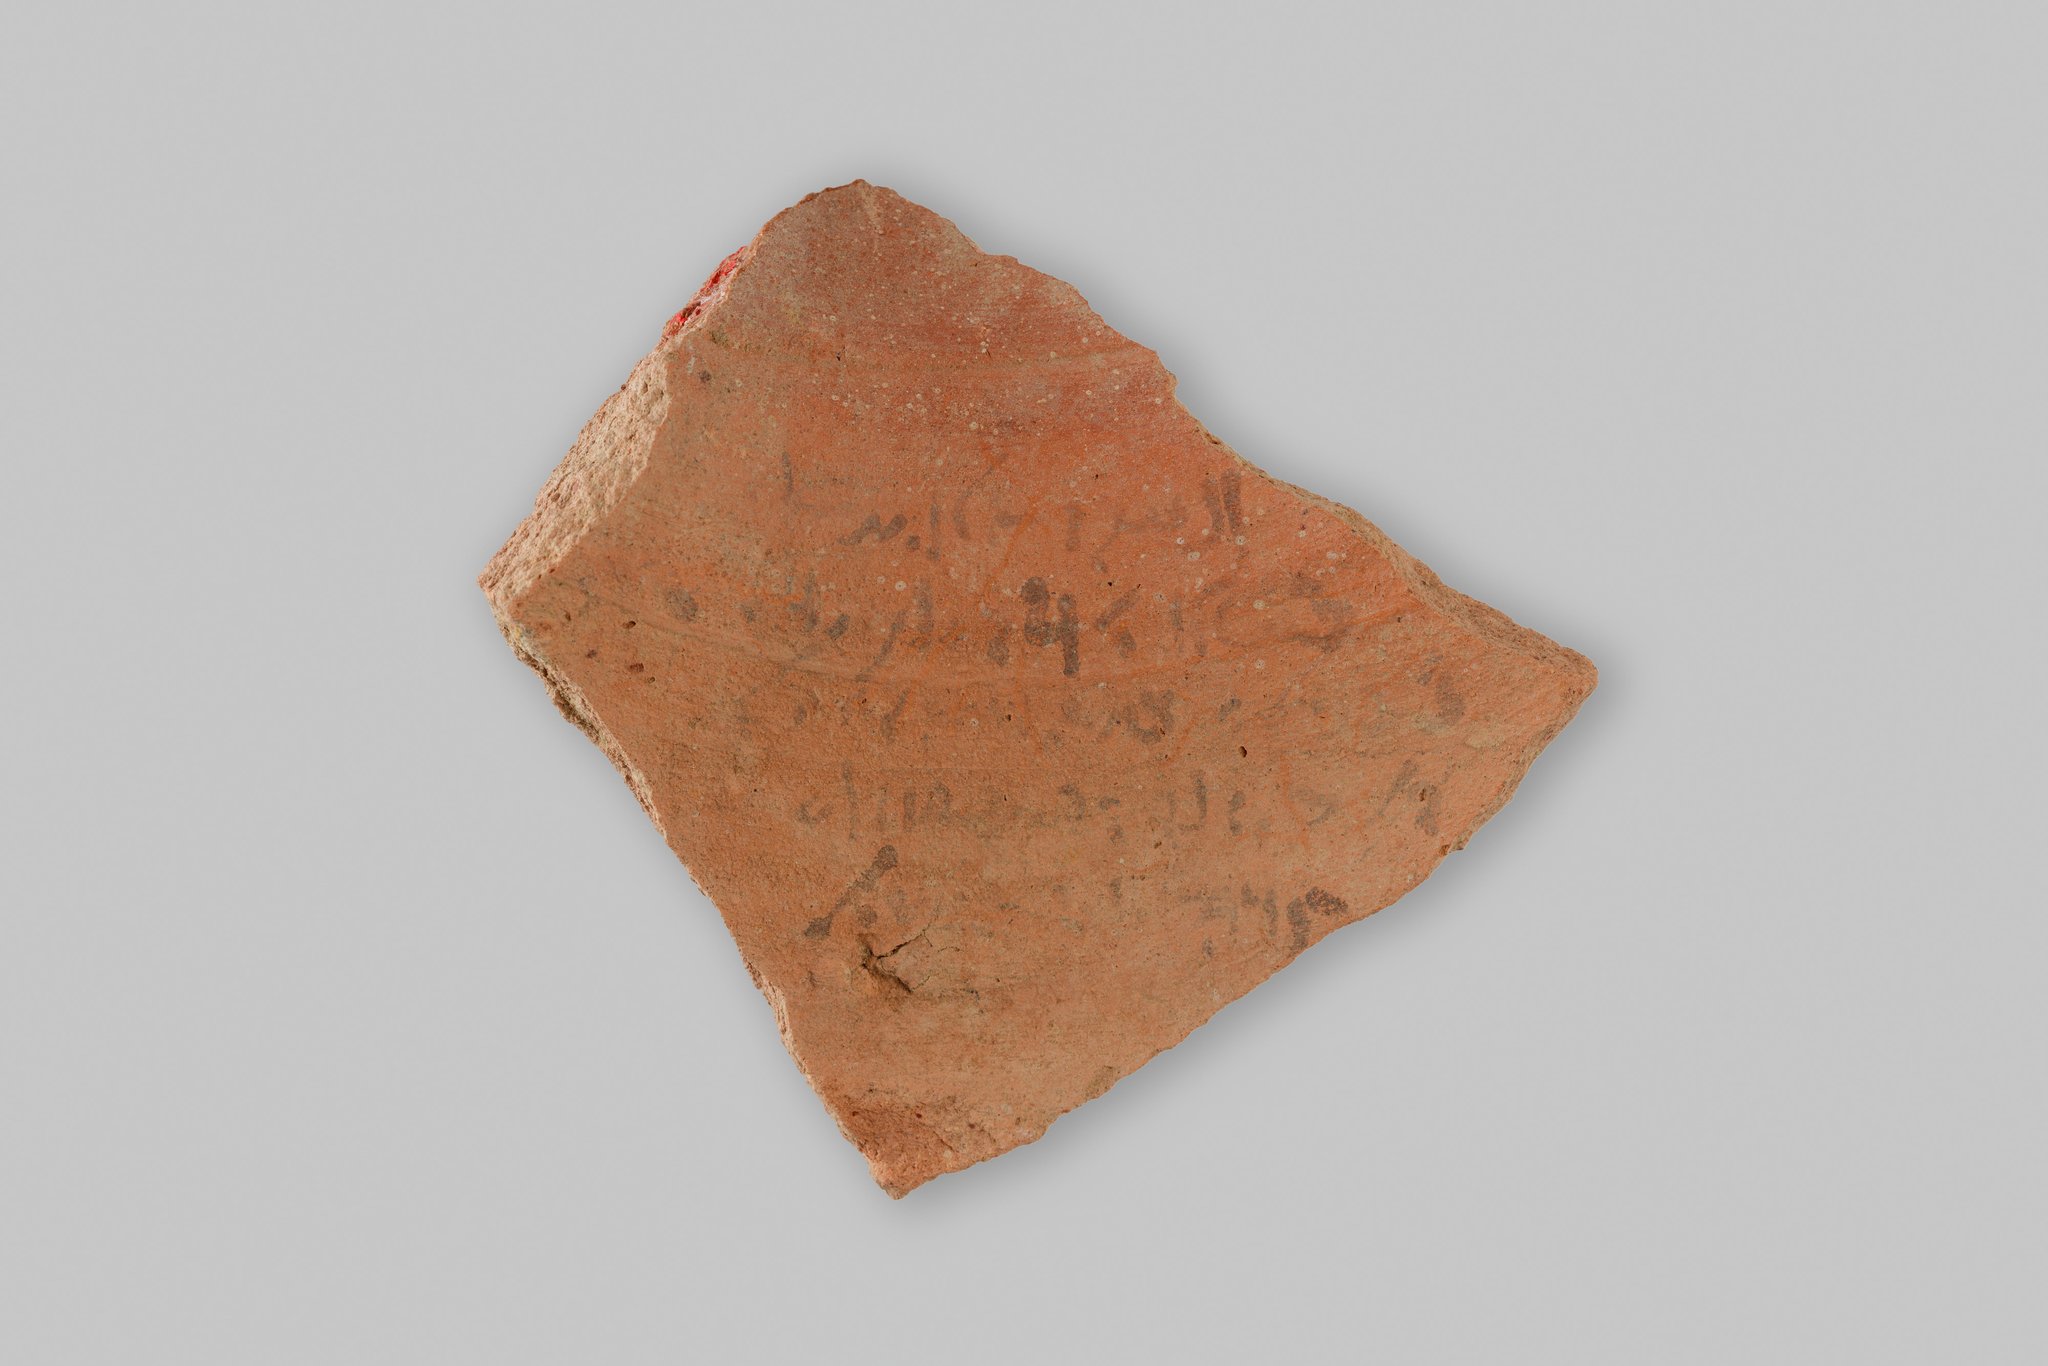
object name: ostracon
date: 400-30 BCE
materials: ink, pottery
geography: egypt